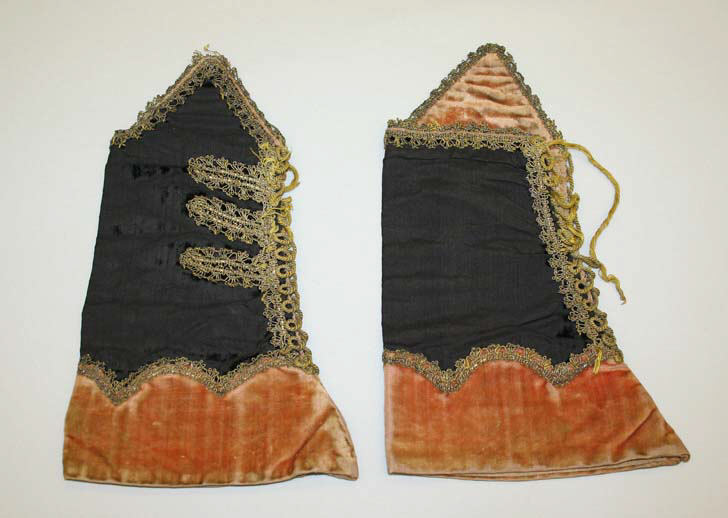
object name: mitt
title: Mitts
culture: italian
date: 1750-1775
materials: metal, silk